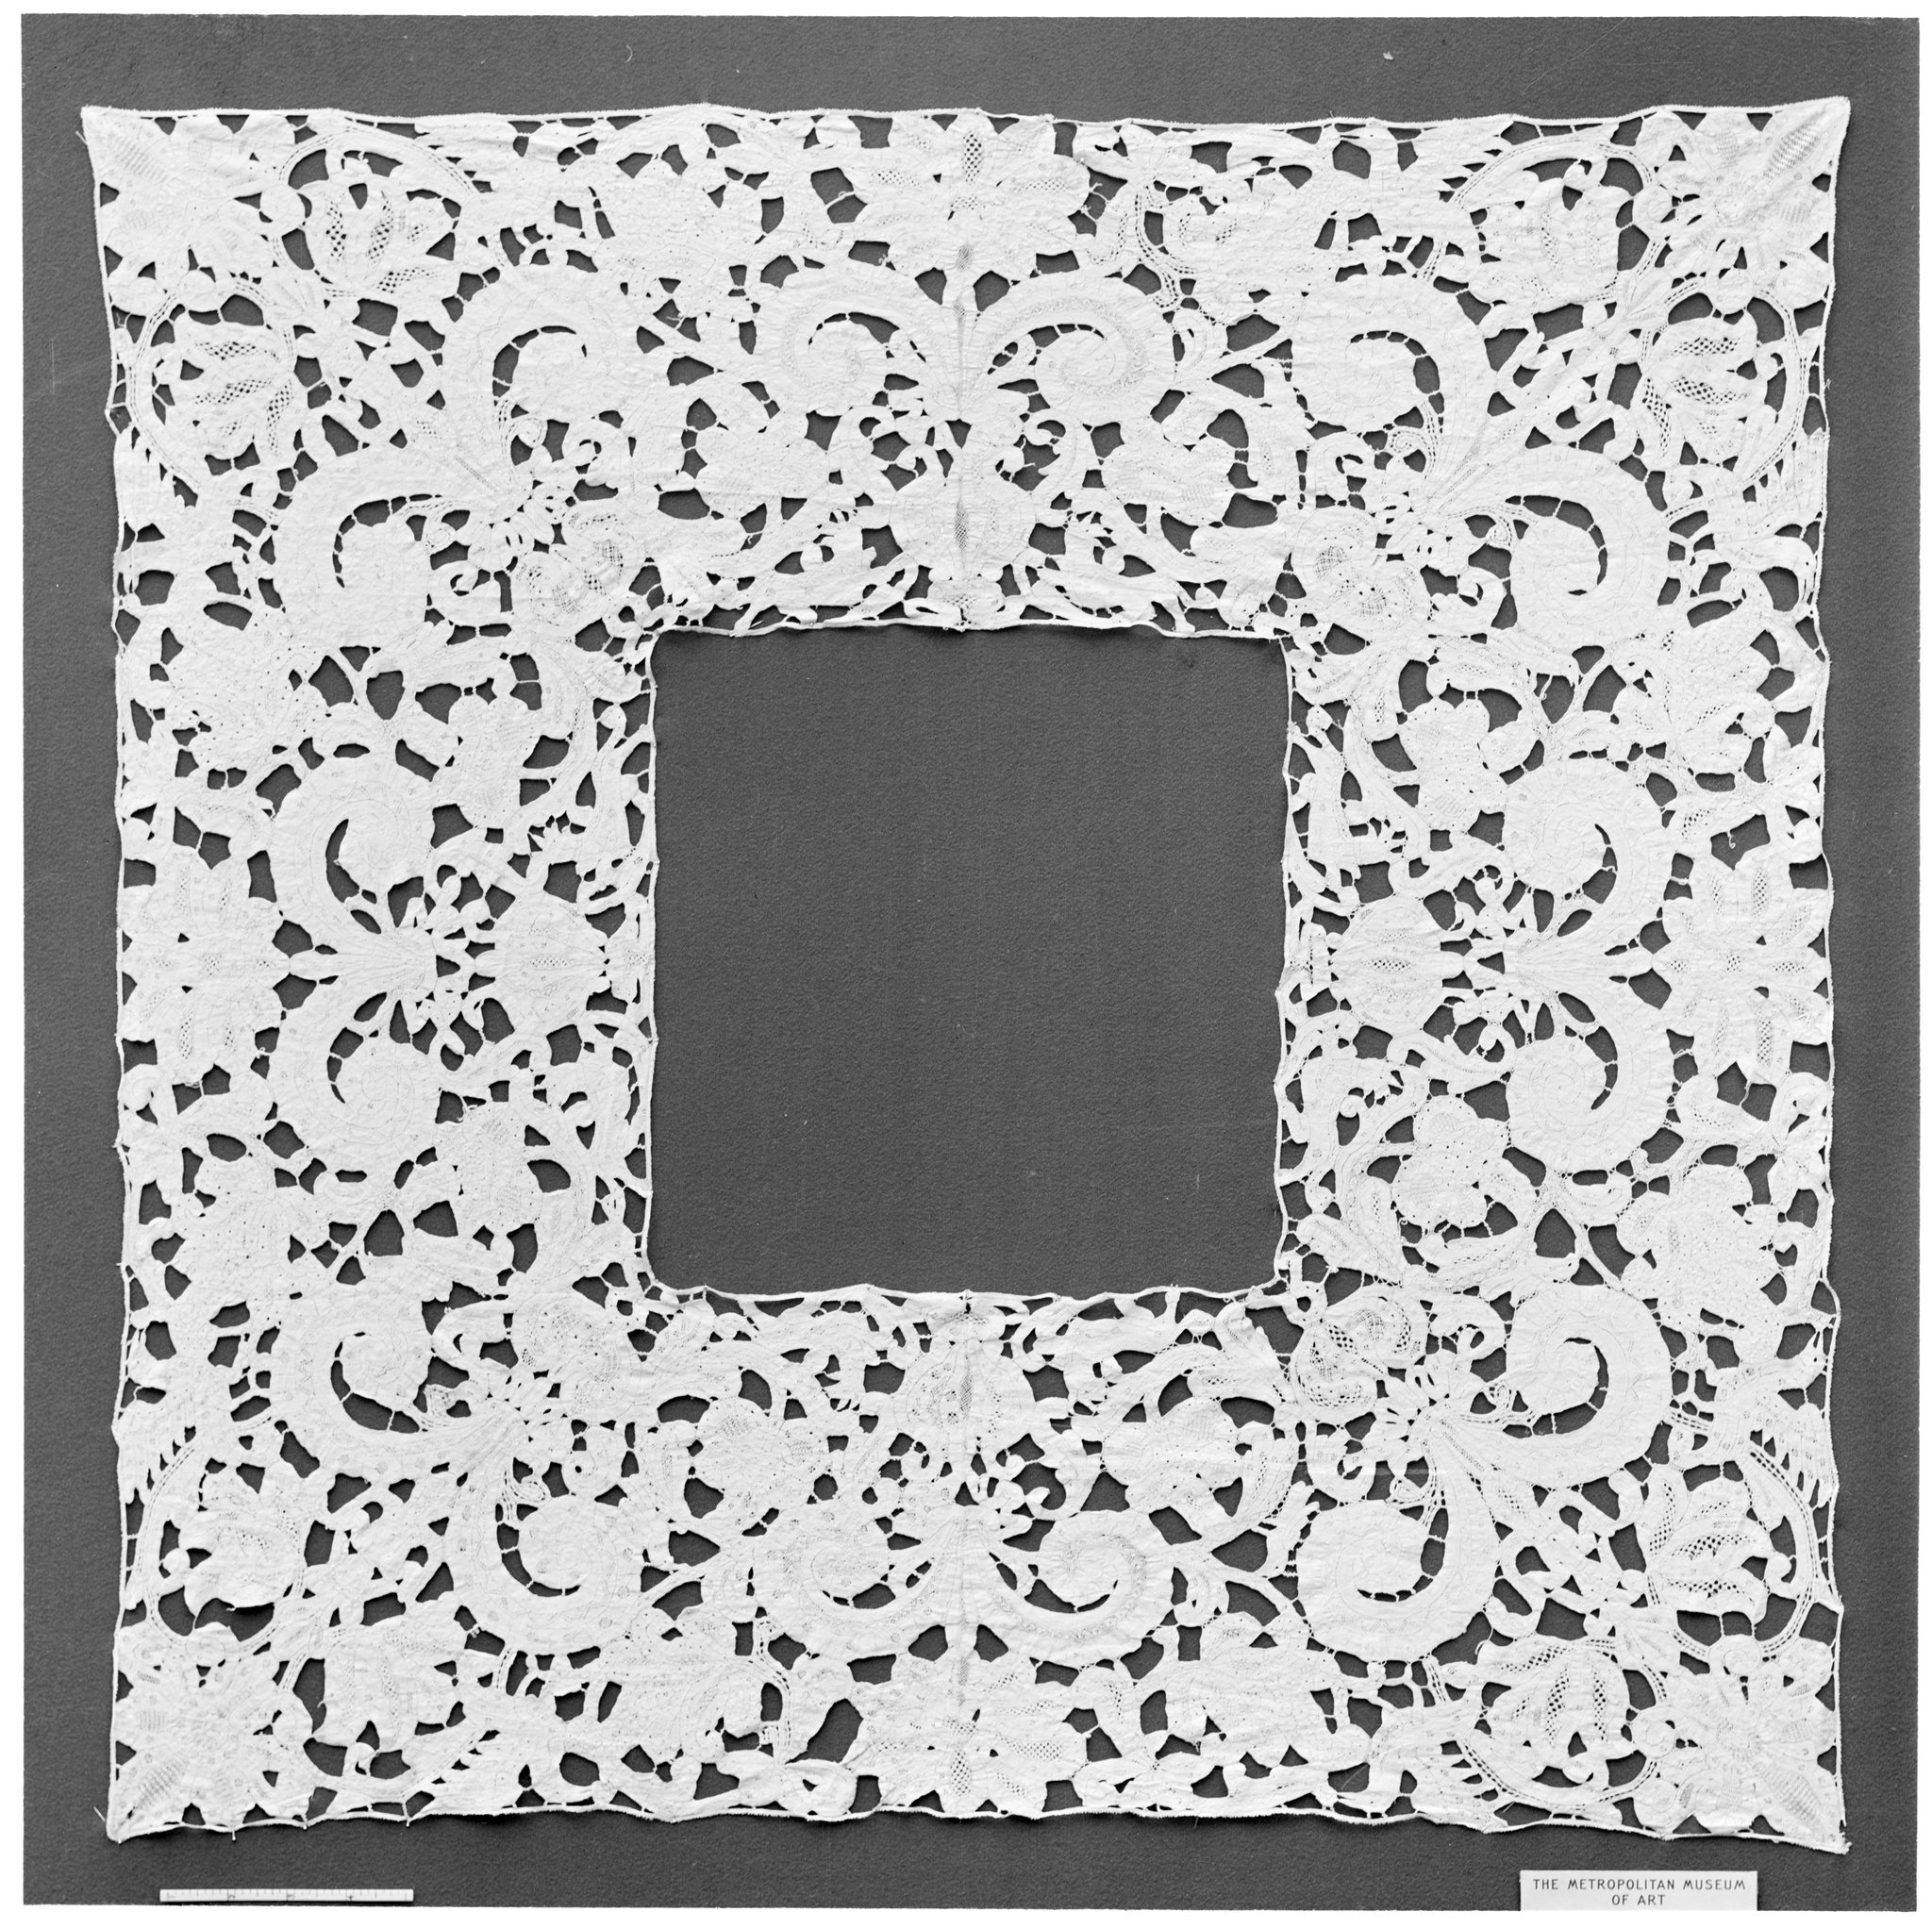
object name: border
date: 1601-1700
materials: lace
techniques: lace